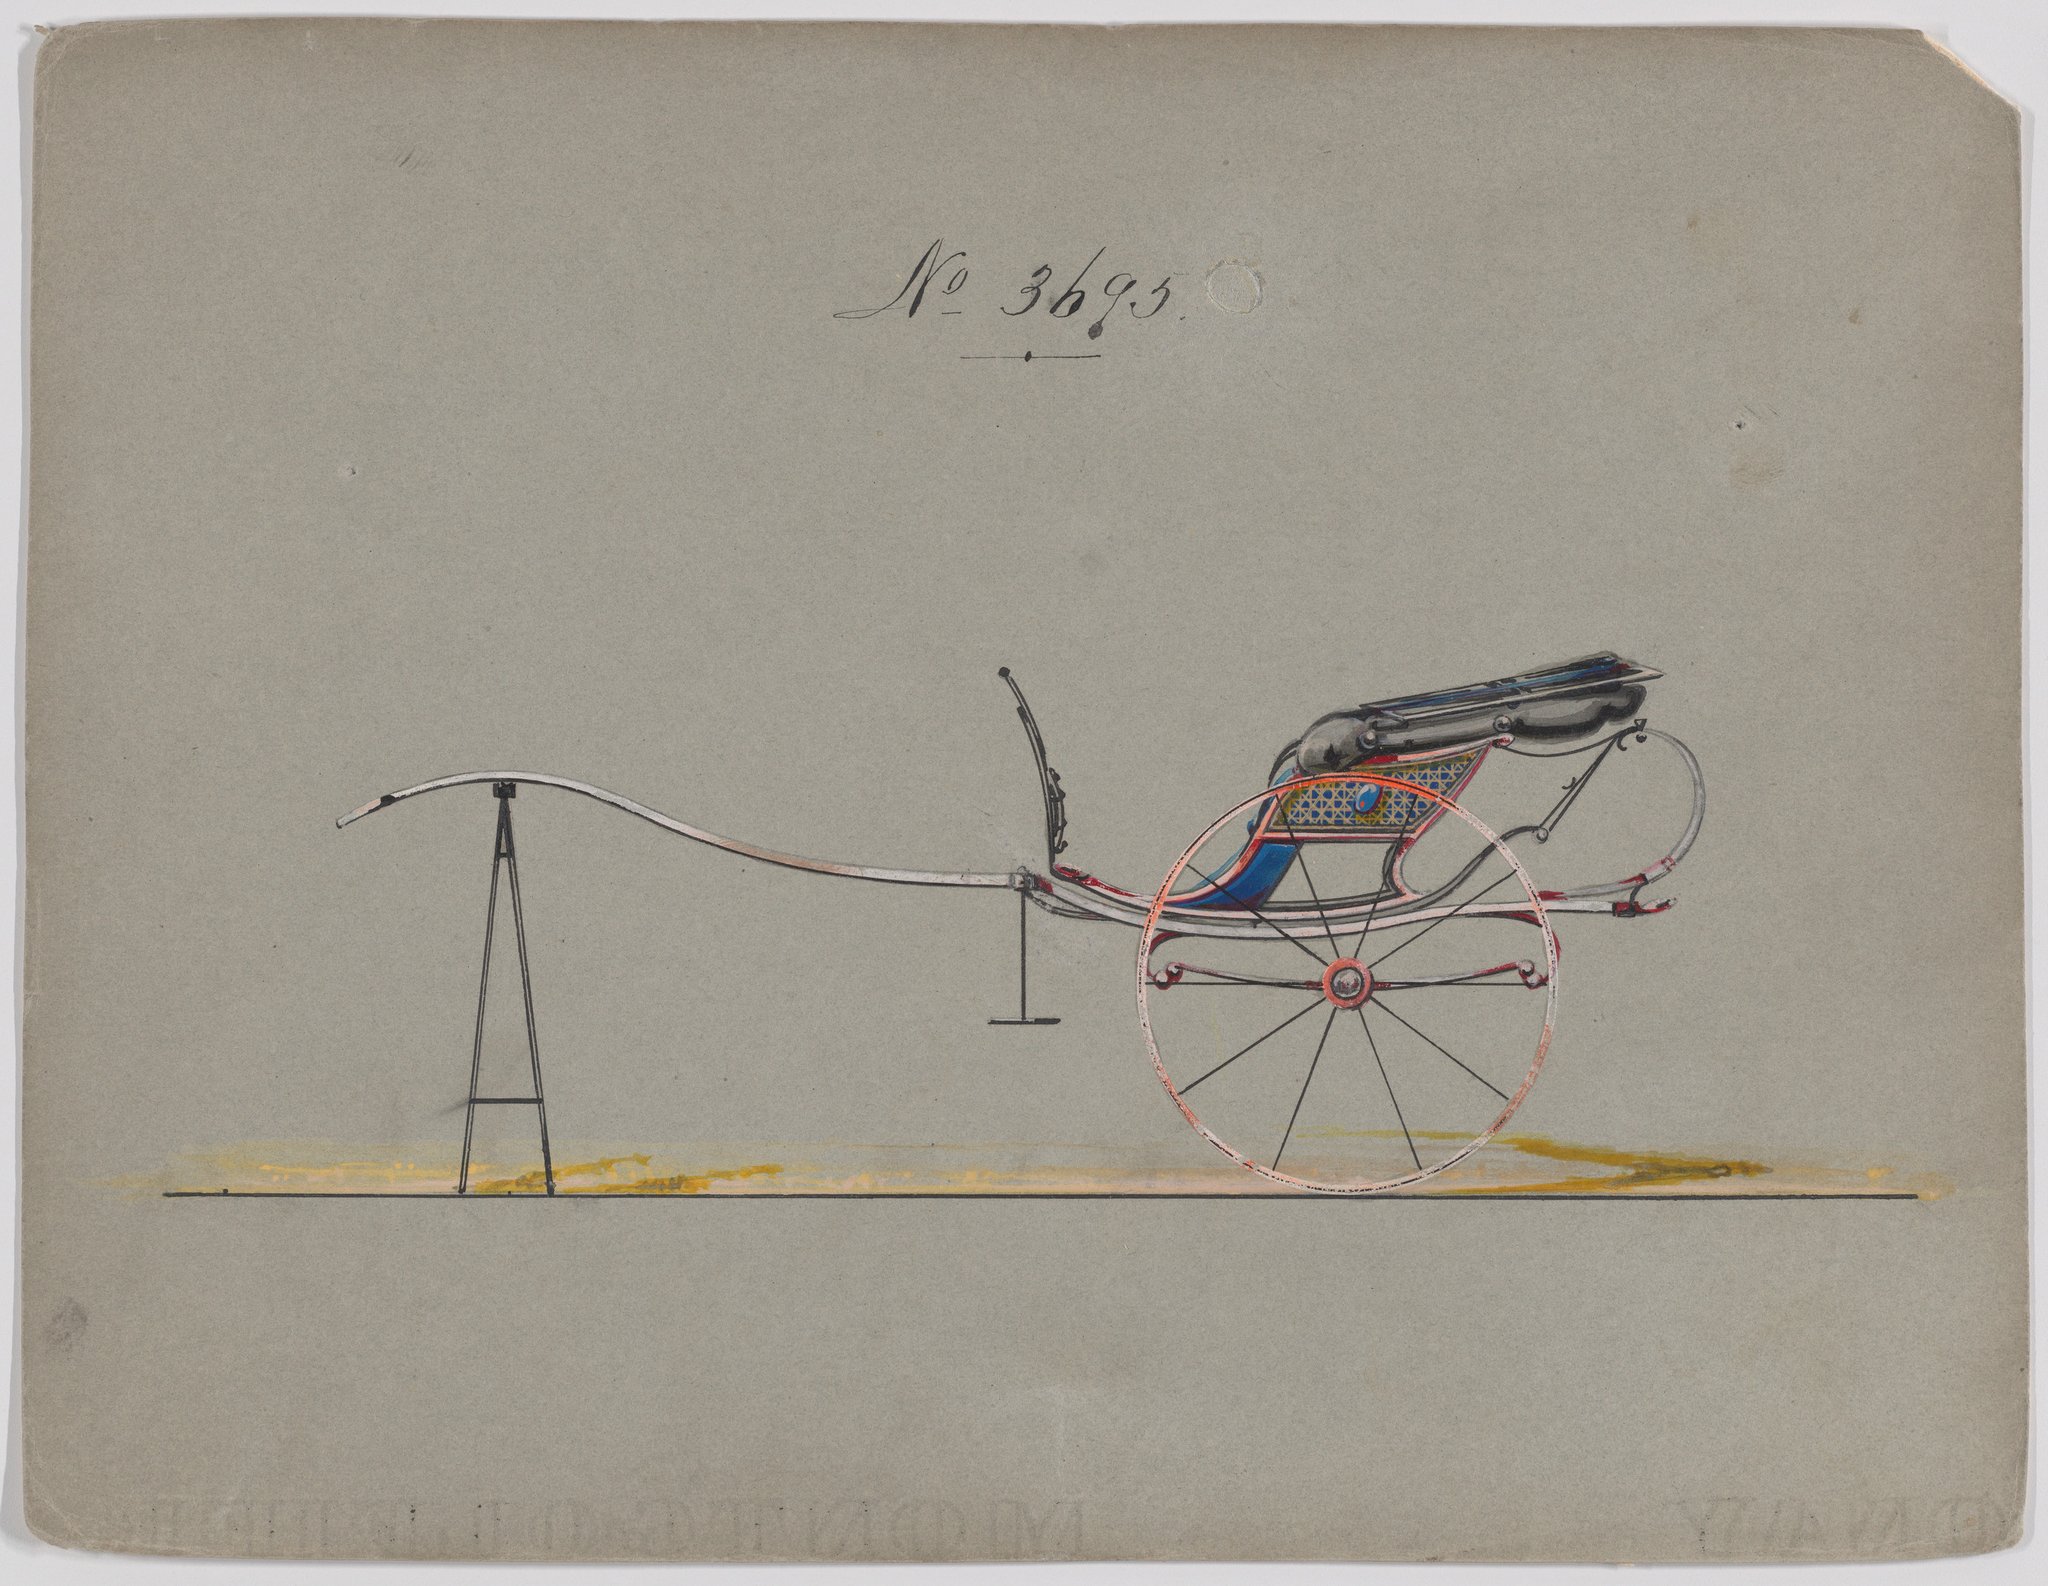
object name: drawing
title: Gig #3695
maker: brewster & co.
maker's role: manufacturer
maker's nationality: american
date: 1881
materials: gouache, gum arabic, watercolor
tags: carriages